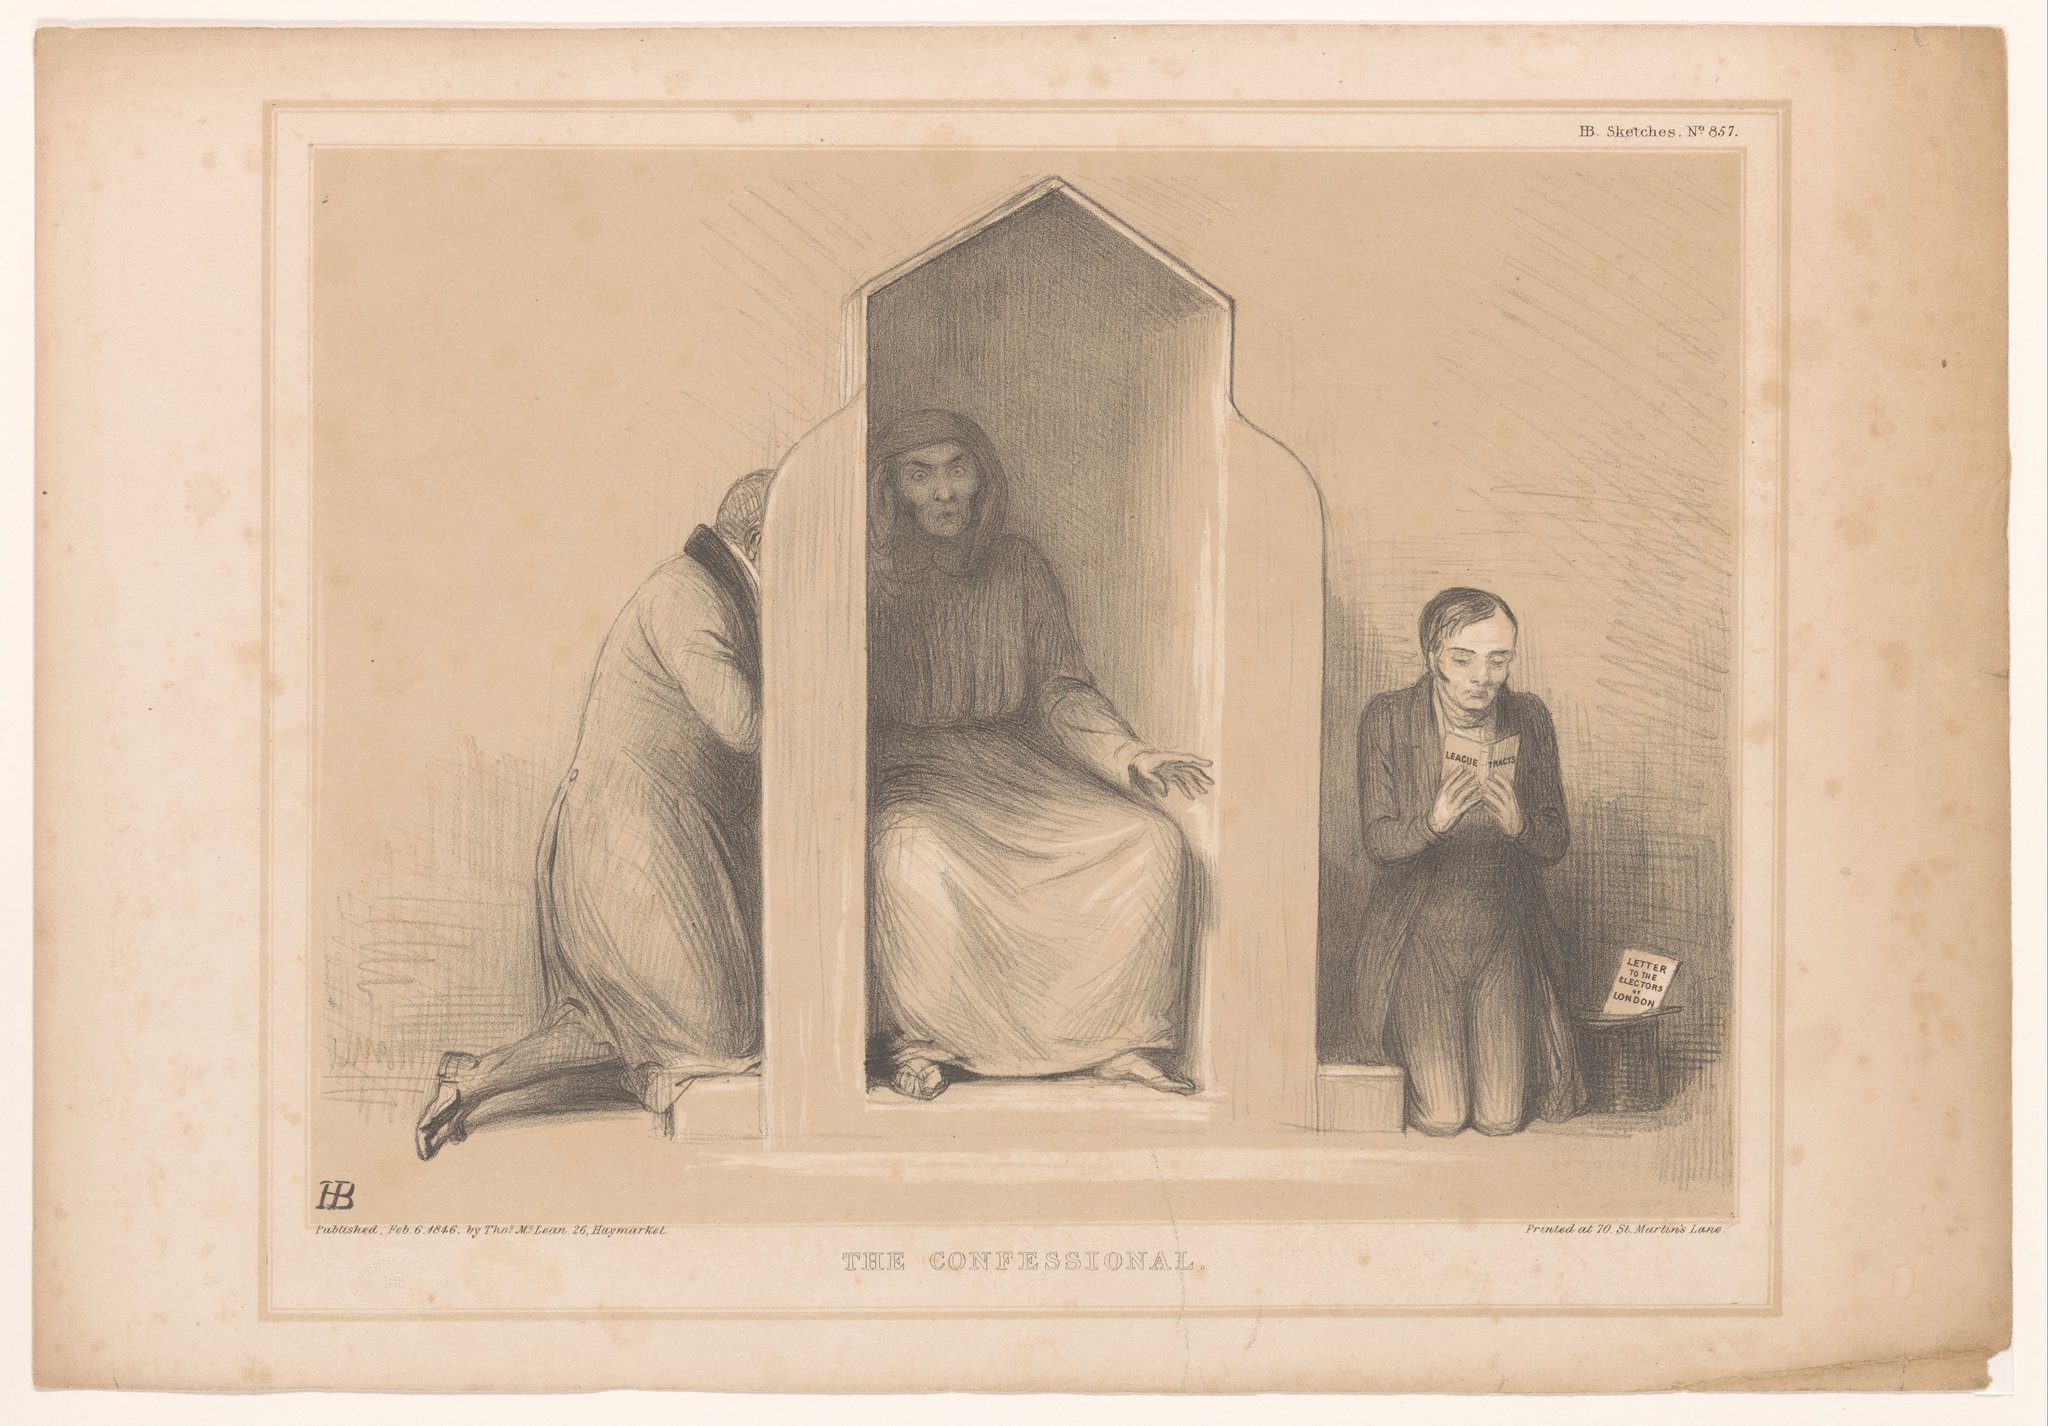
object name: cartoon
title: HB Sketches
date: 1846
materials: paper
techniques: tone lithography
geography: london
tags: politician, confession; 'confessione sacramentale' (ripa) ~ the third of the seven sacraments, political caricatures and satires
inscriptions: stamp: ‘HB Subscribers Copy’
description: Spotprent uit 1846 met John Arthur Roebuck die als biechtvader in verbazing een biecht aanhoort. Uitgegeven als nr. 857 in de serie HB Sketches.